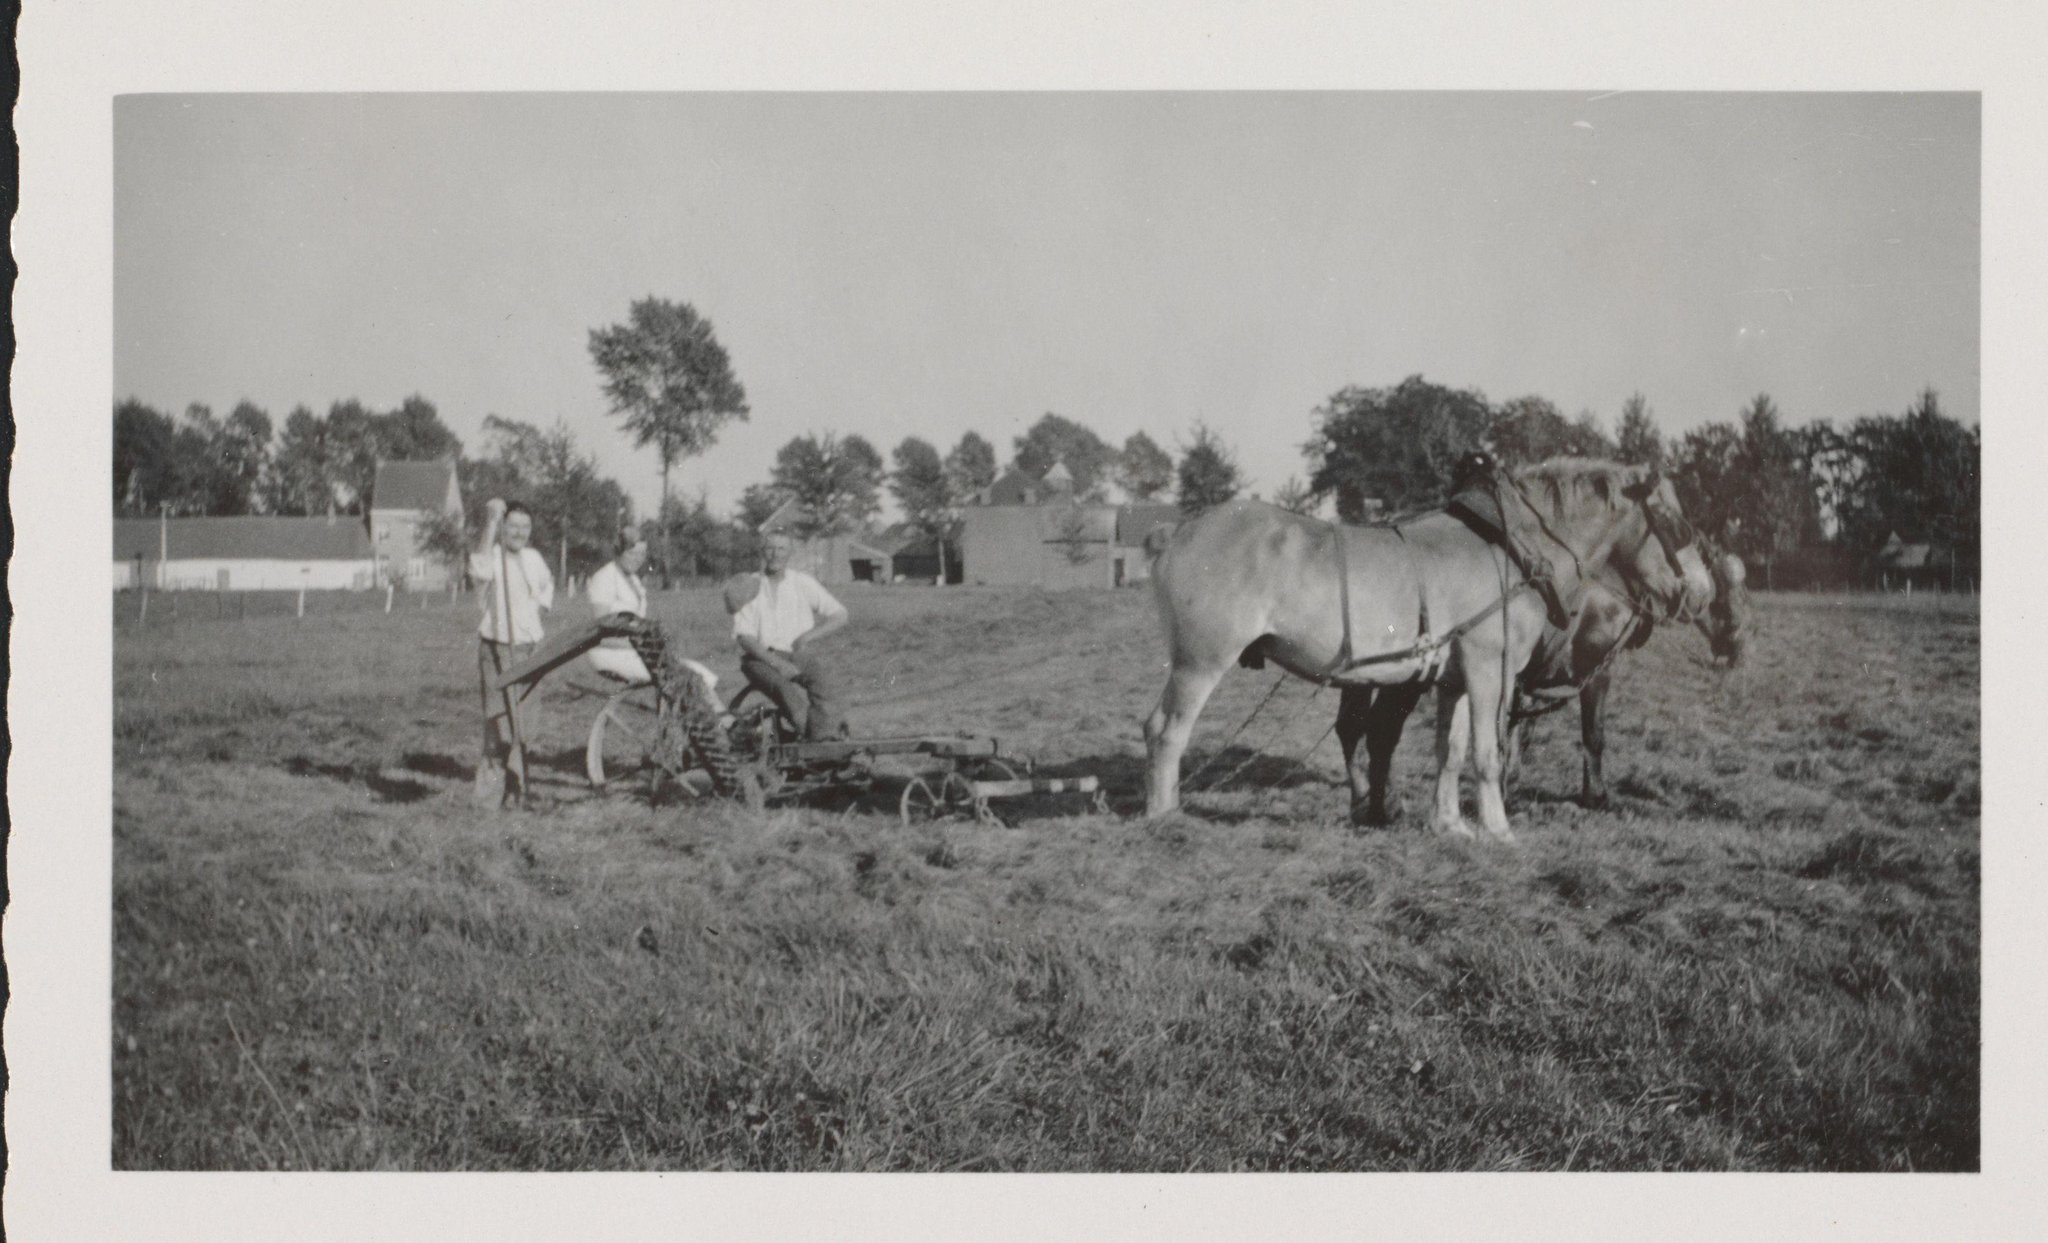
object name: photograph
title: Twee mannen en G.A. Brusse-Urtebise bij een door paarden getrokken landbouwwerktuig in Andricourt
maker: Anonymous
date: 1925-1940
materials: photographic support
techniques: gelatin silver print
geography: andricourt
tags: farmers, horse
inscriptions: inscription: ‘Andricourt les travaux devant la maison’